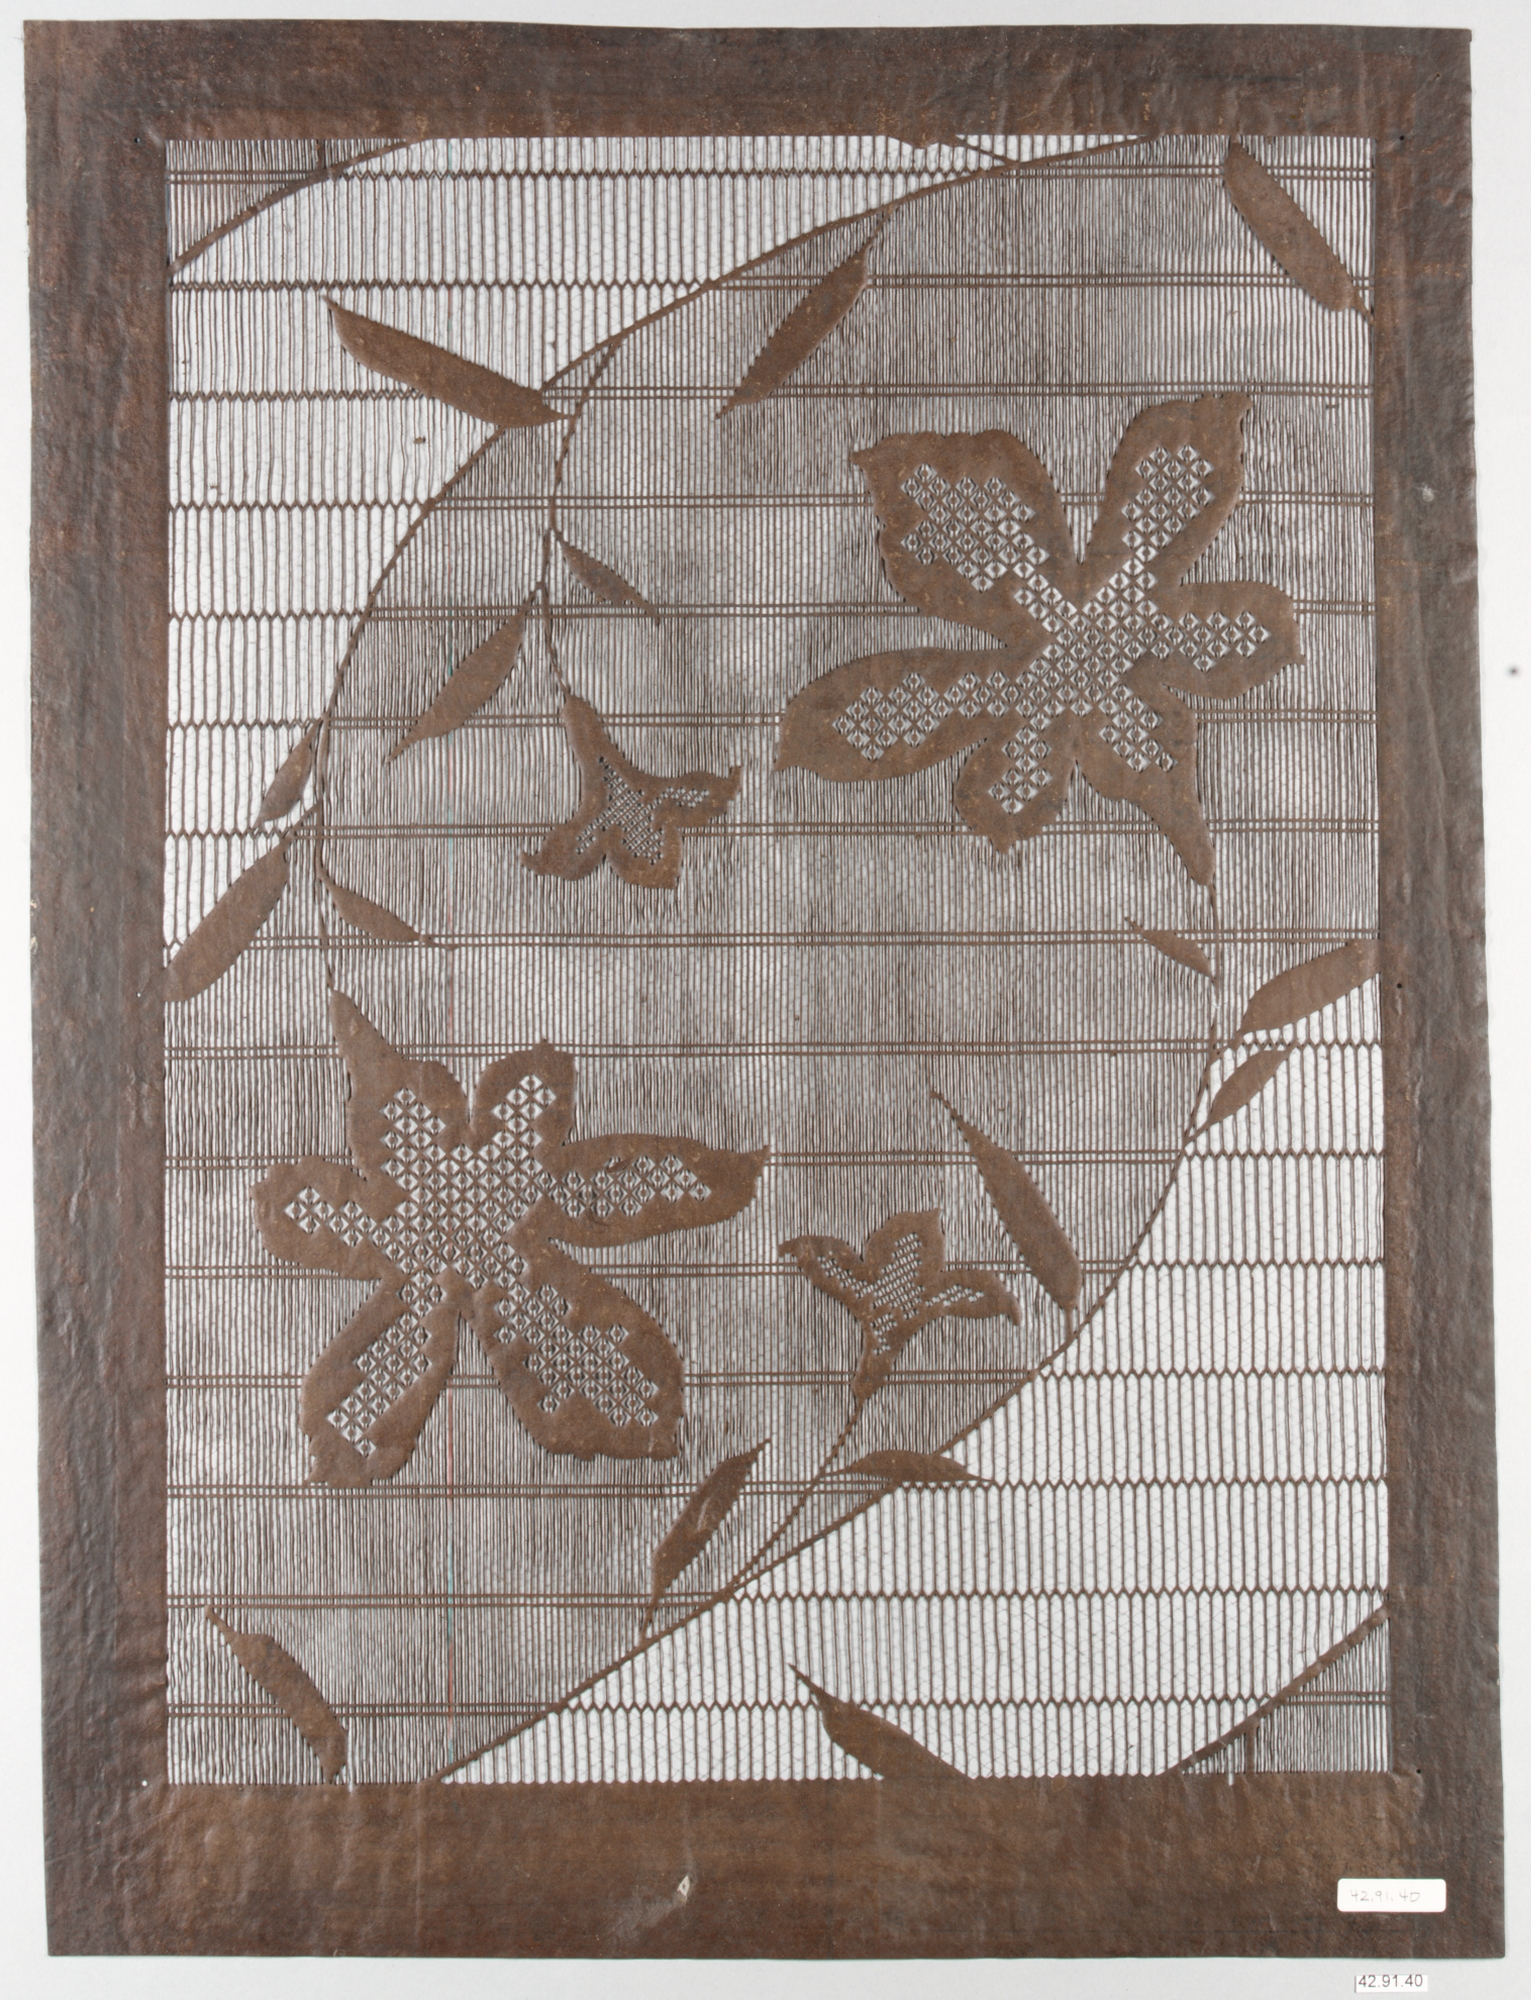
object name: stencil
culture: japanese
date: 1801-1900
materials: paper, silk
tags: leaves